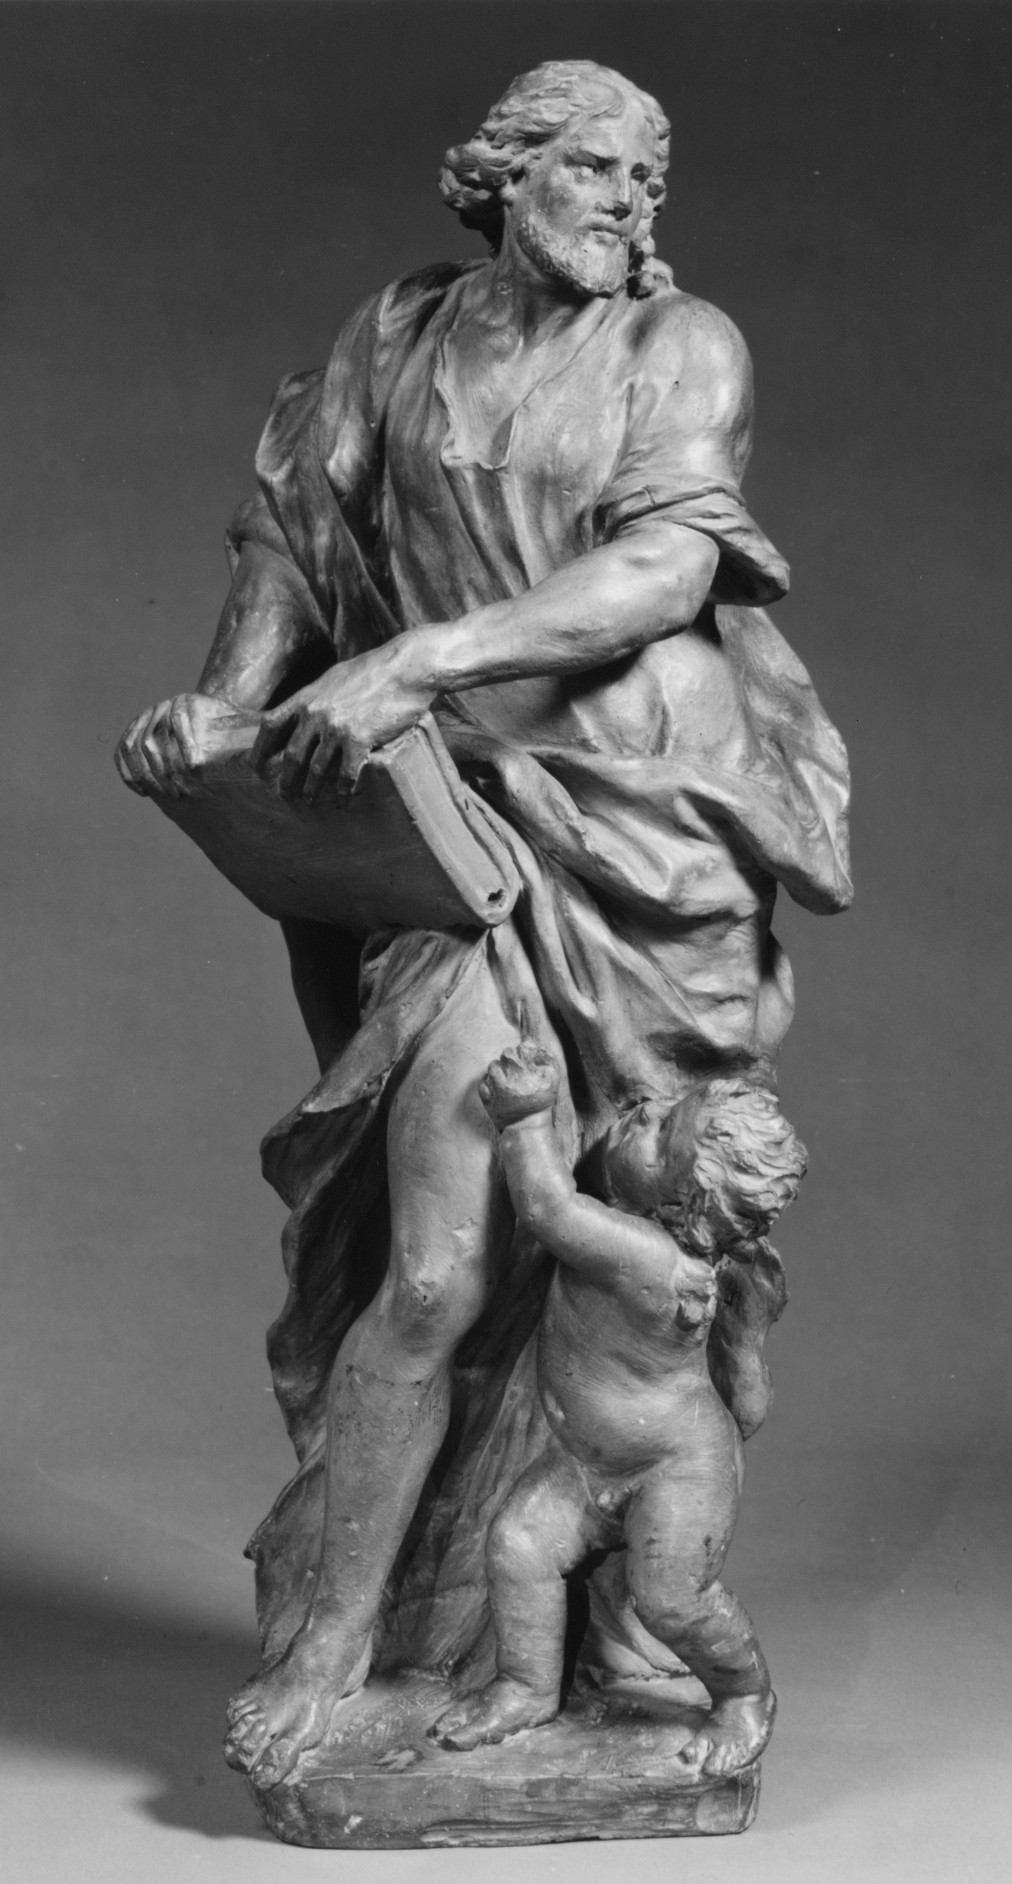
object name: statuette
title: Saint Matthew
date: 1700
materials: terracotta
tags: putti,saint matthew